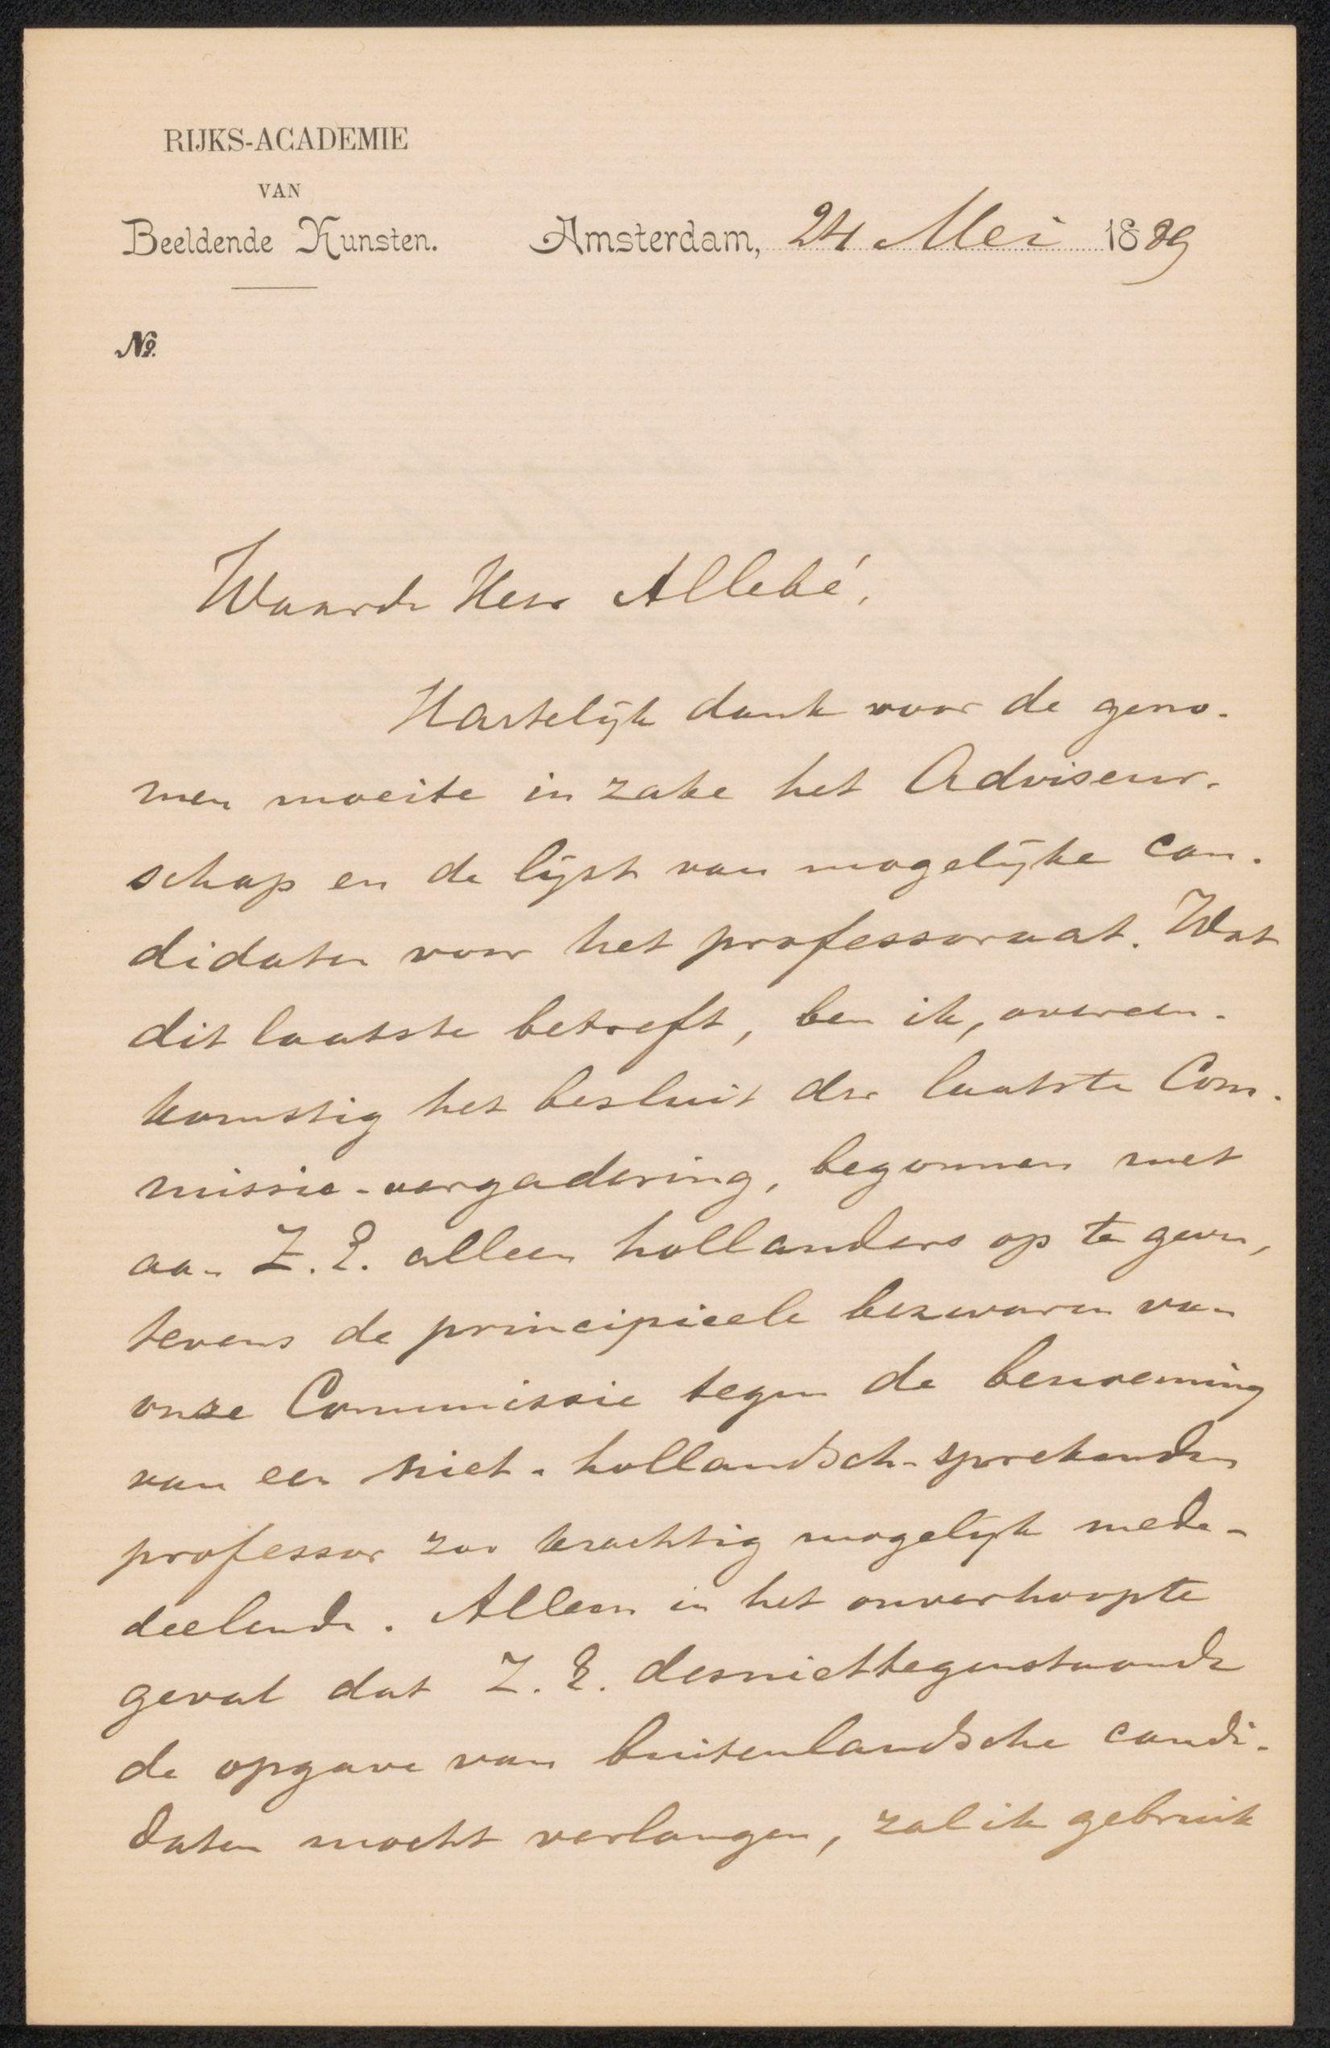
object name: letter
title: Brief aan August Allebé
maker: jérôme alexander sillem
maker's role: politician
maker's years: 1840-1912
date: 1889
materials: ink, paper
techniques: pen, printing, writing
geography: amsterdam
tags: essen, publisher, karl baedeker, august allebé, print maker, draughtsman, paul rink, education, tuition of the artist (in general)